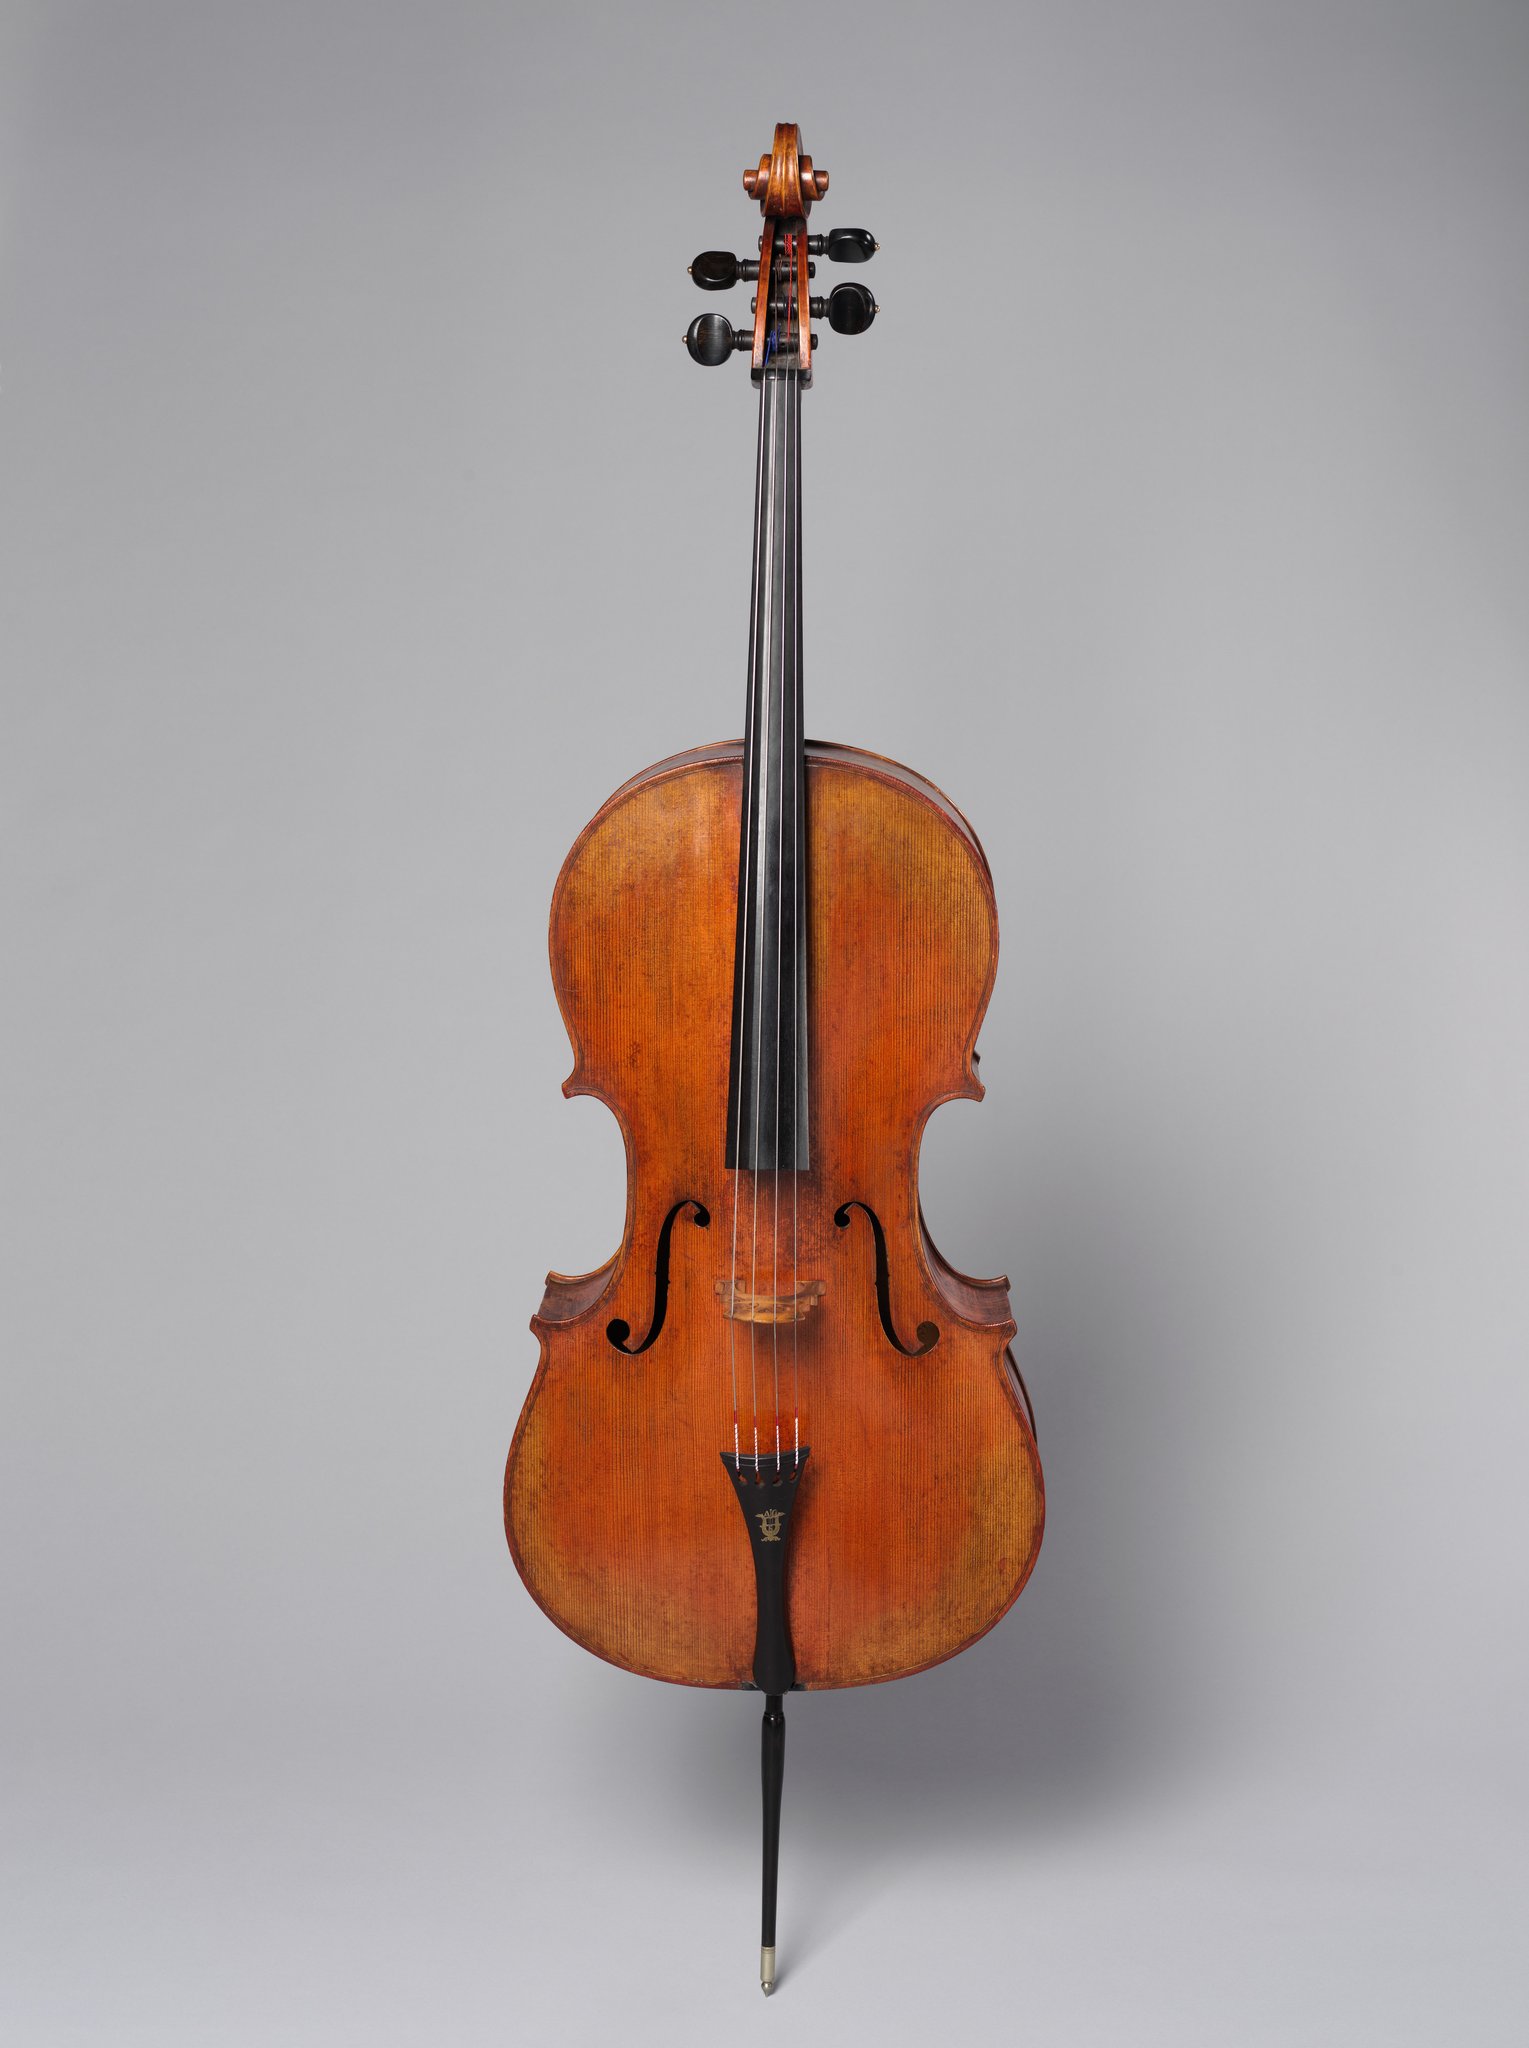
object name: violoncello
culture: american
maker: august martin gemünder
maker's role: artist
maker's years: 1862-1928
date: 1893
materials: wood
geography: united states